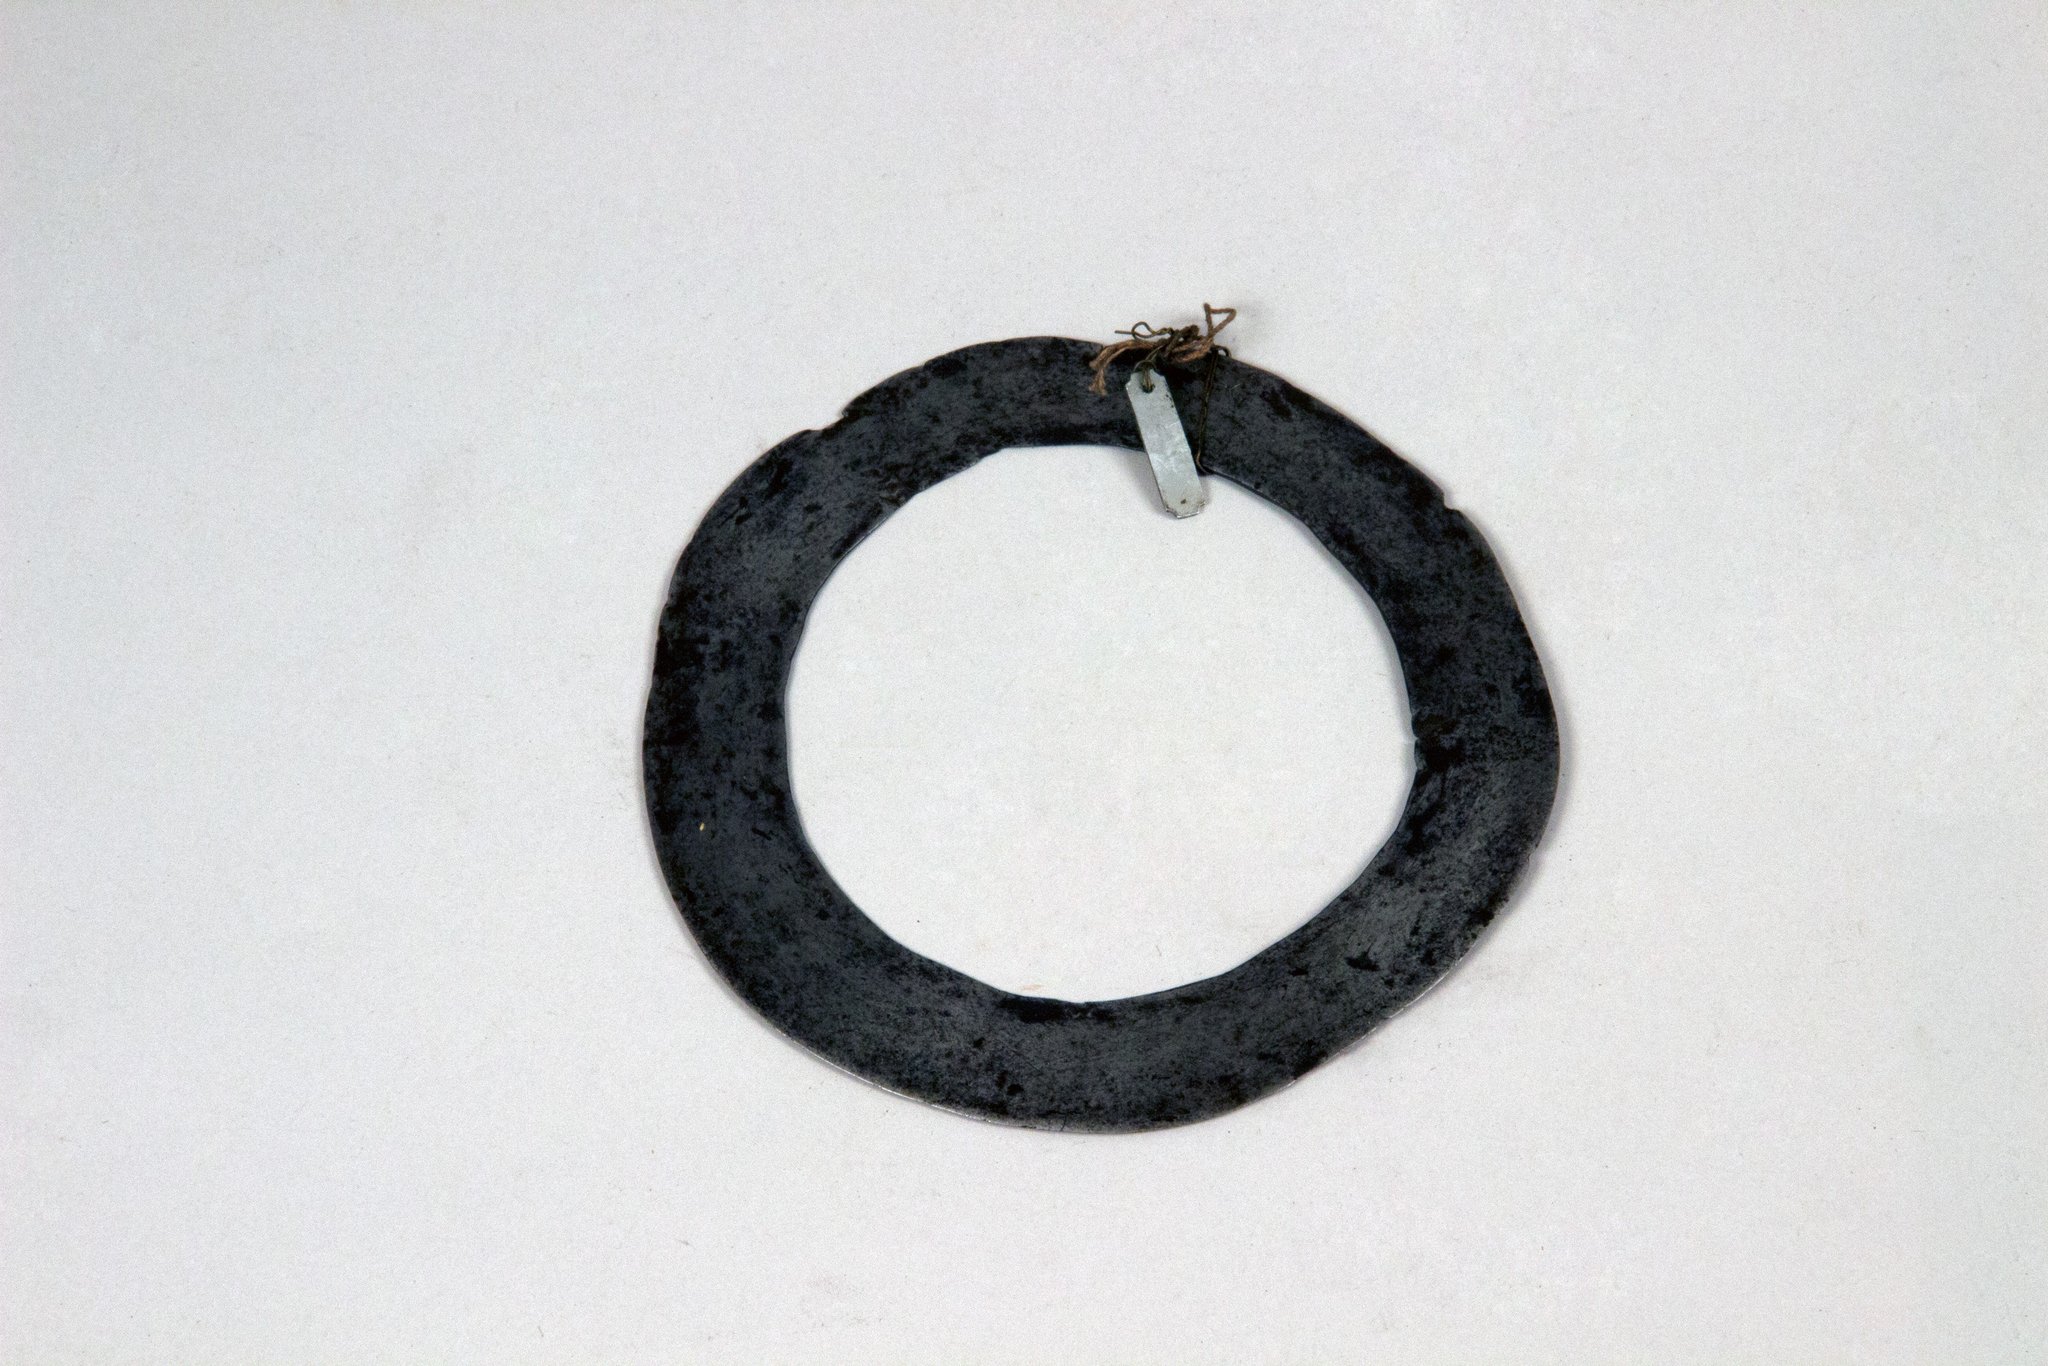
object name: quoit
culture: indian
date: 1601-1700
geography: india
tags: games